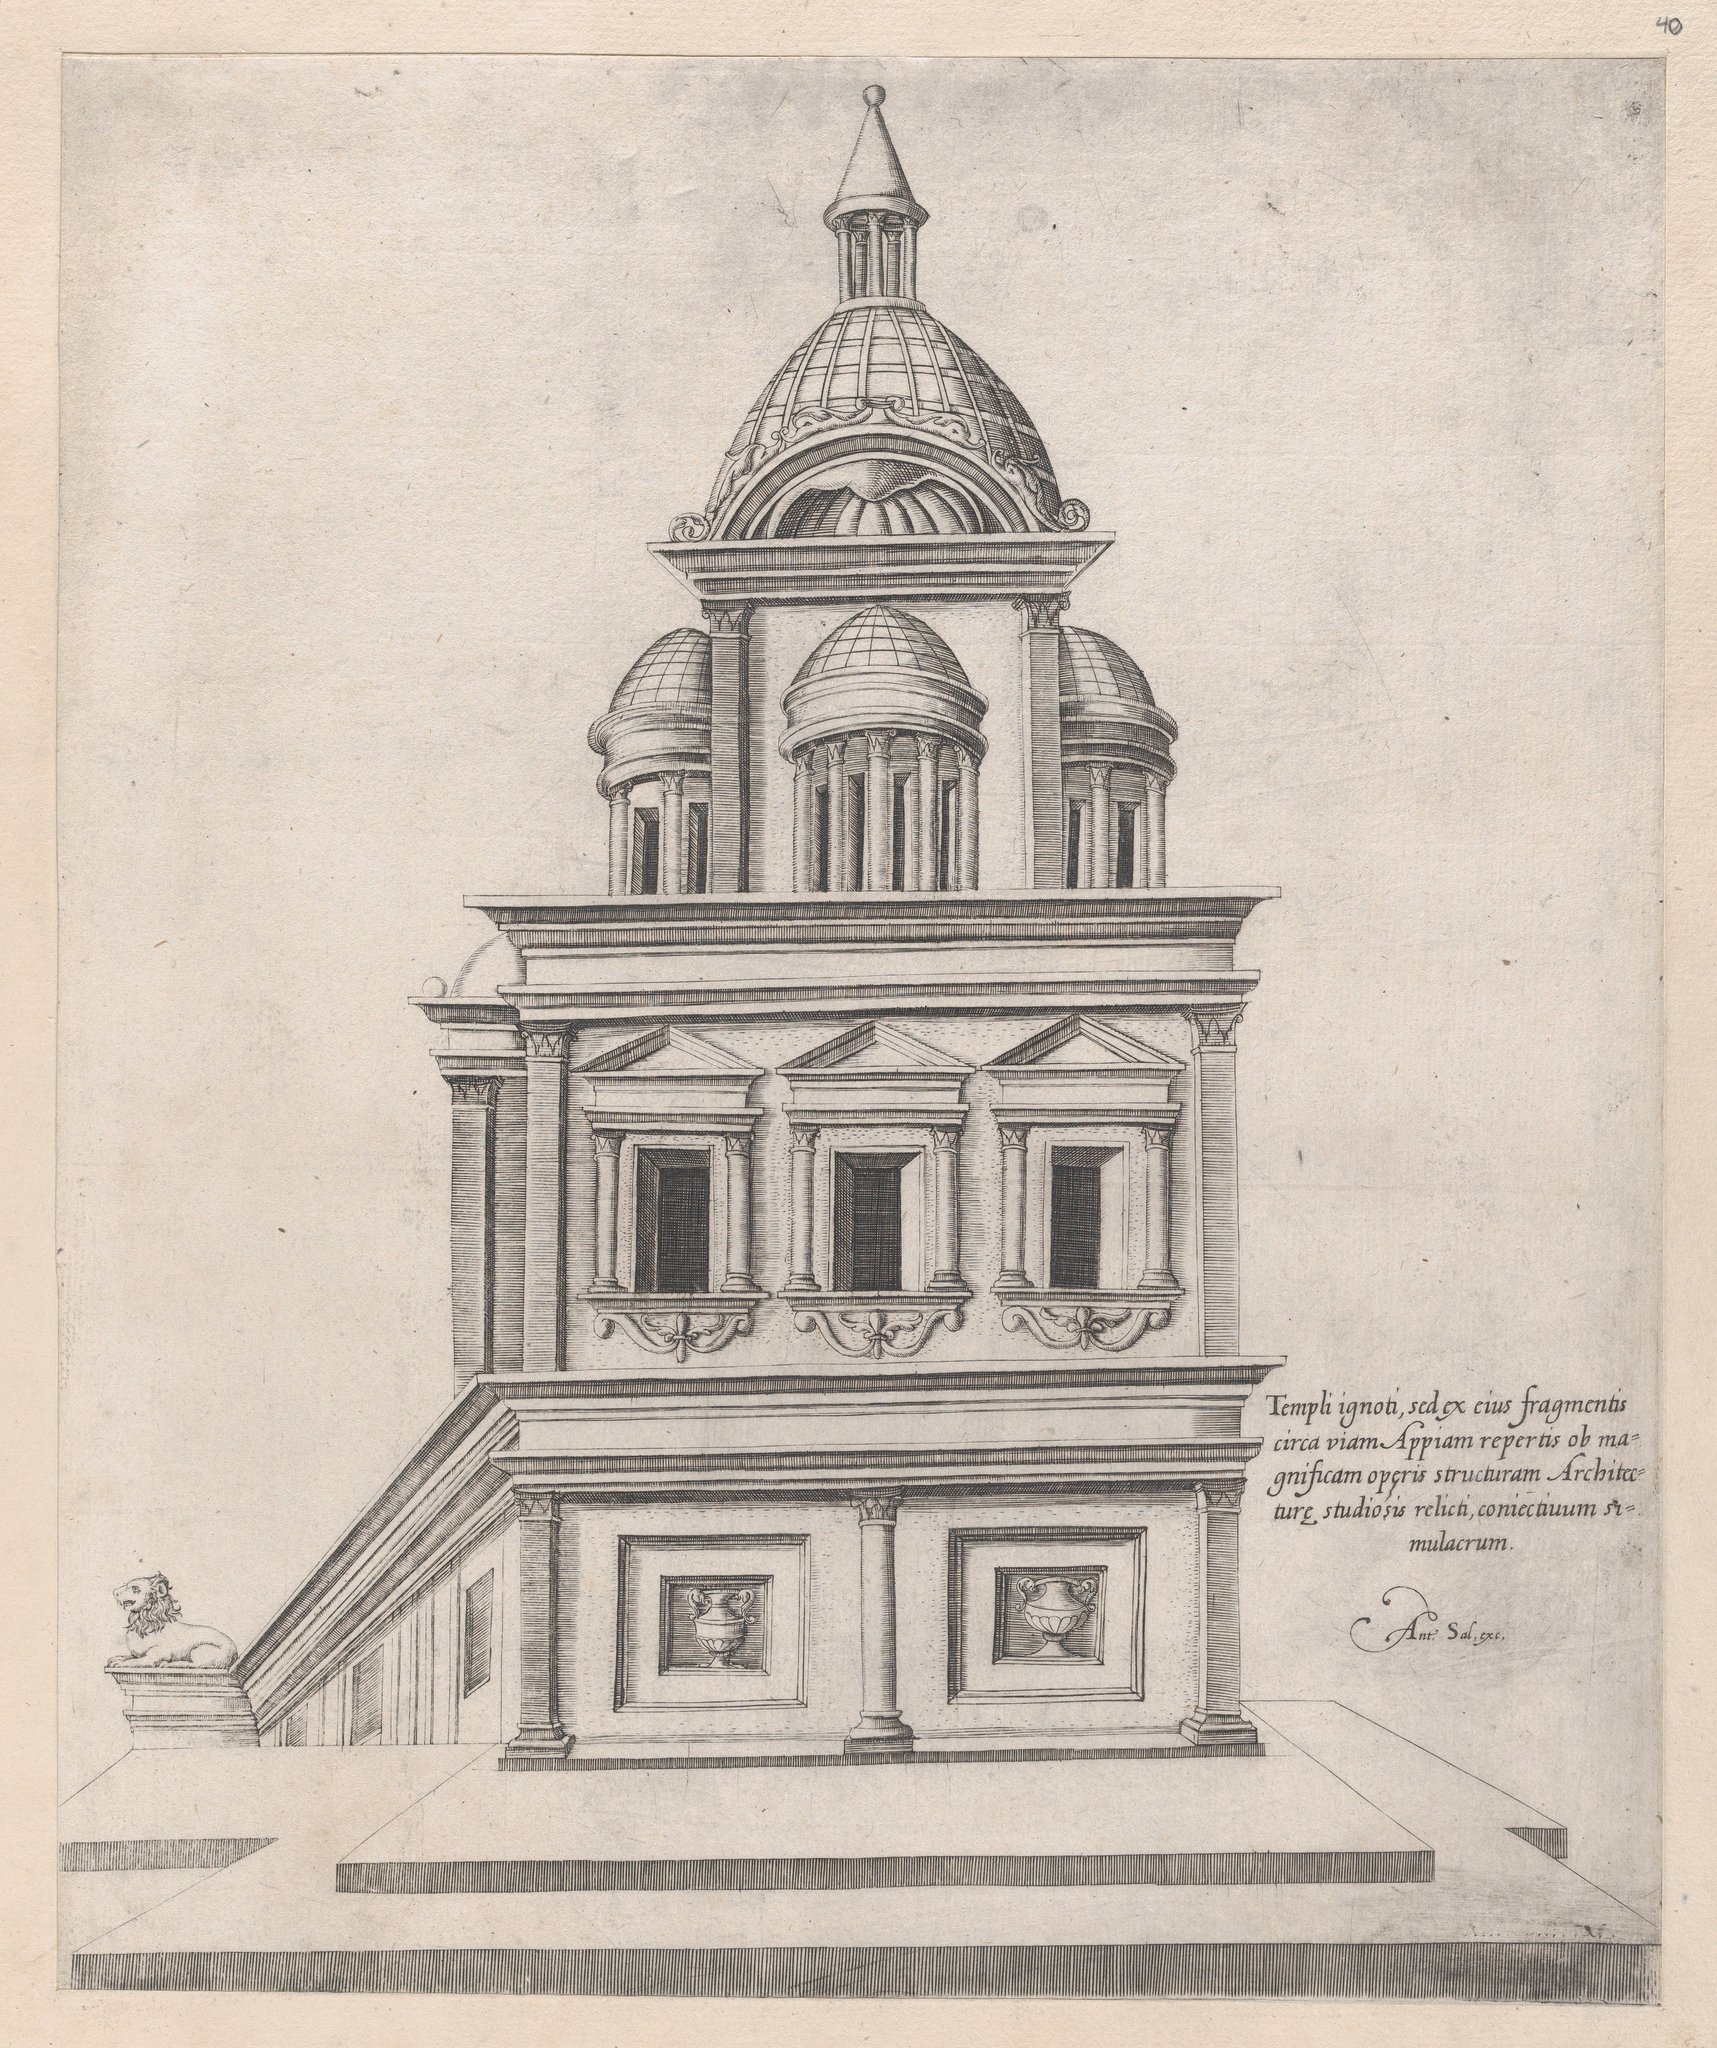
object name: print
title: Temple near the Appian Way, from "Speculum Romanae Magnificentiae"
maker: Anonymous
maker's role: artist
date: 1501-1600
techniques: engraving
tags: temples,rome